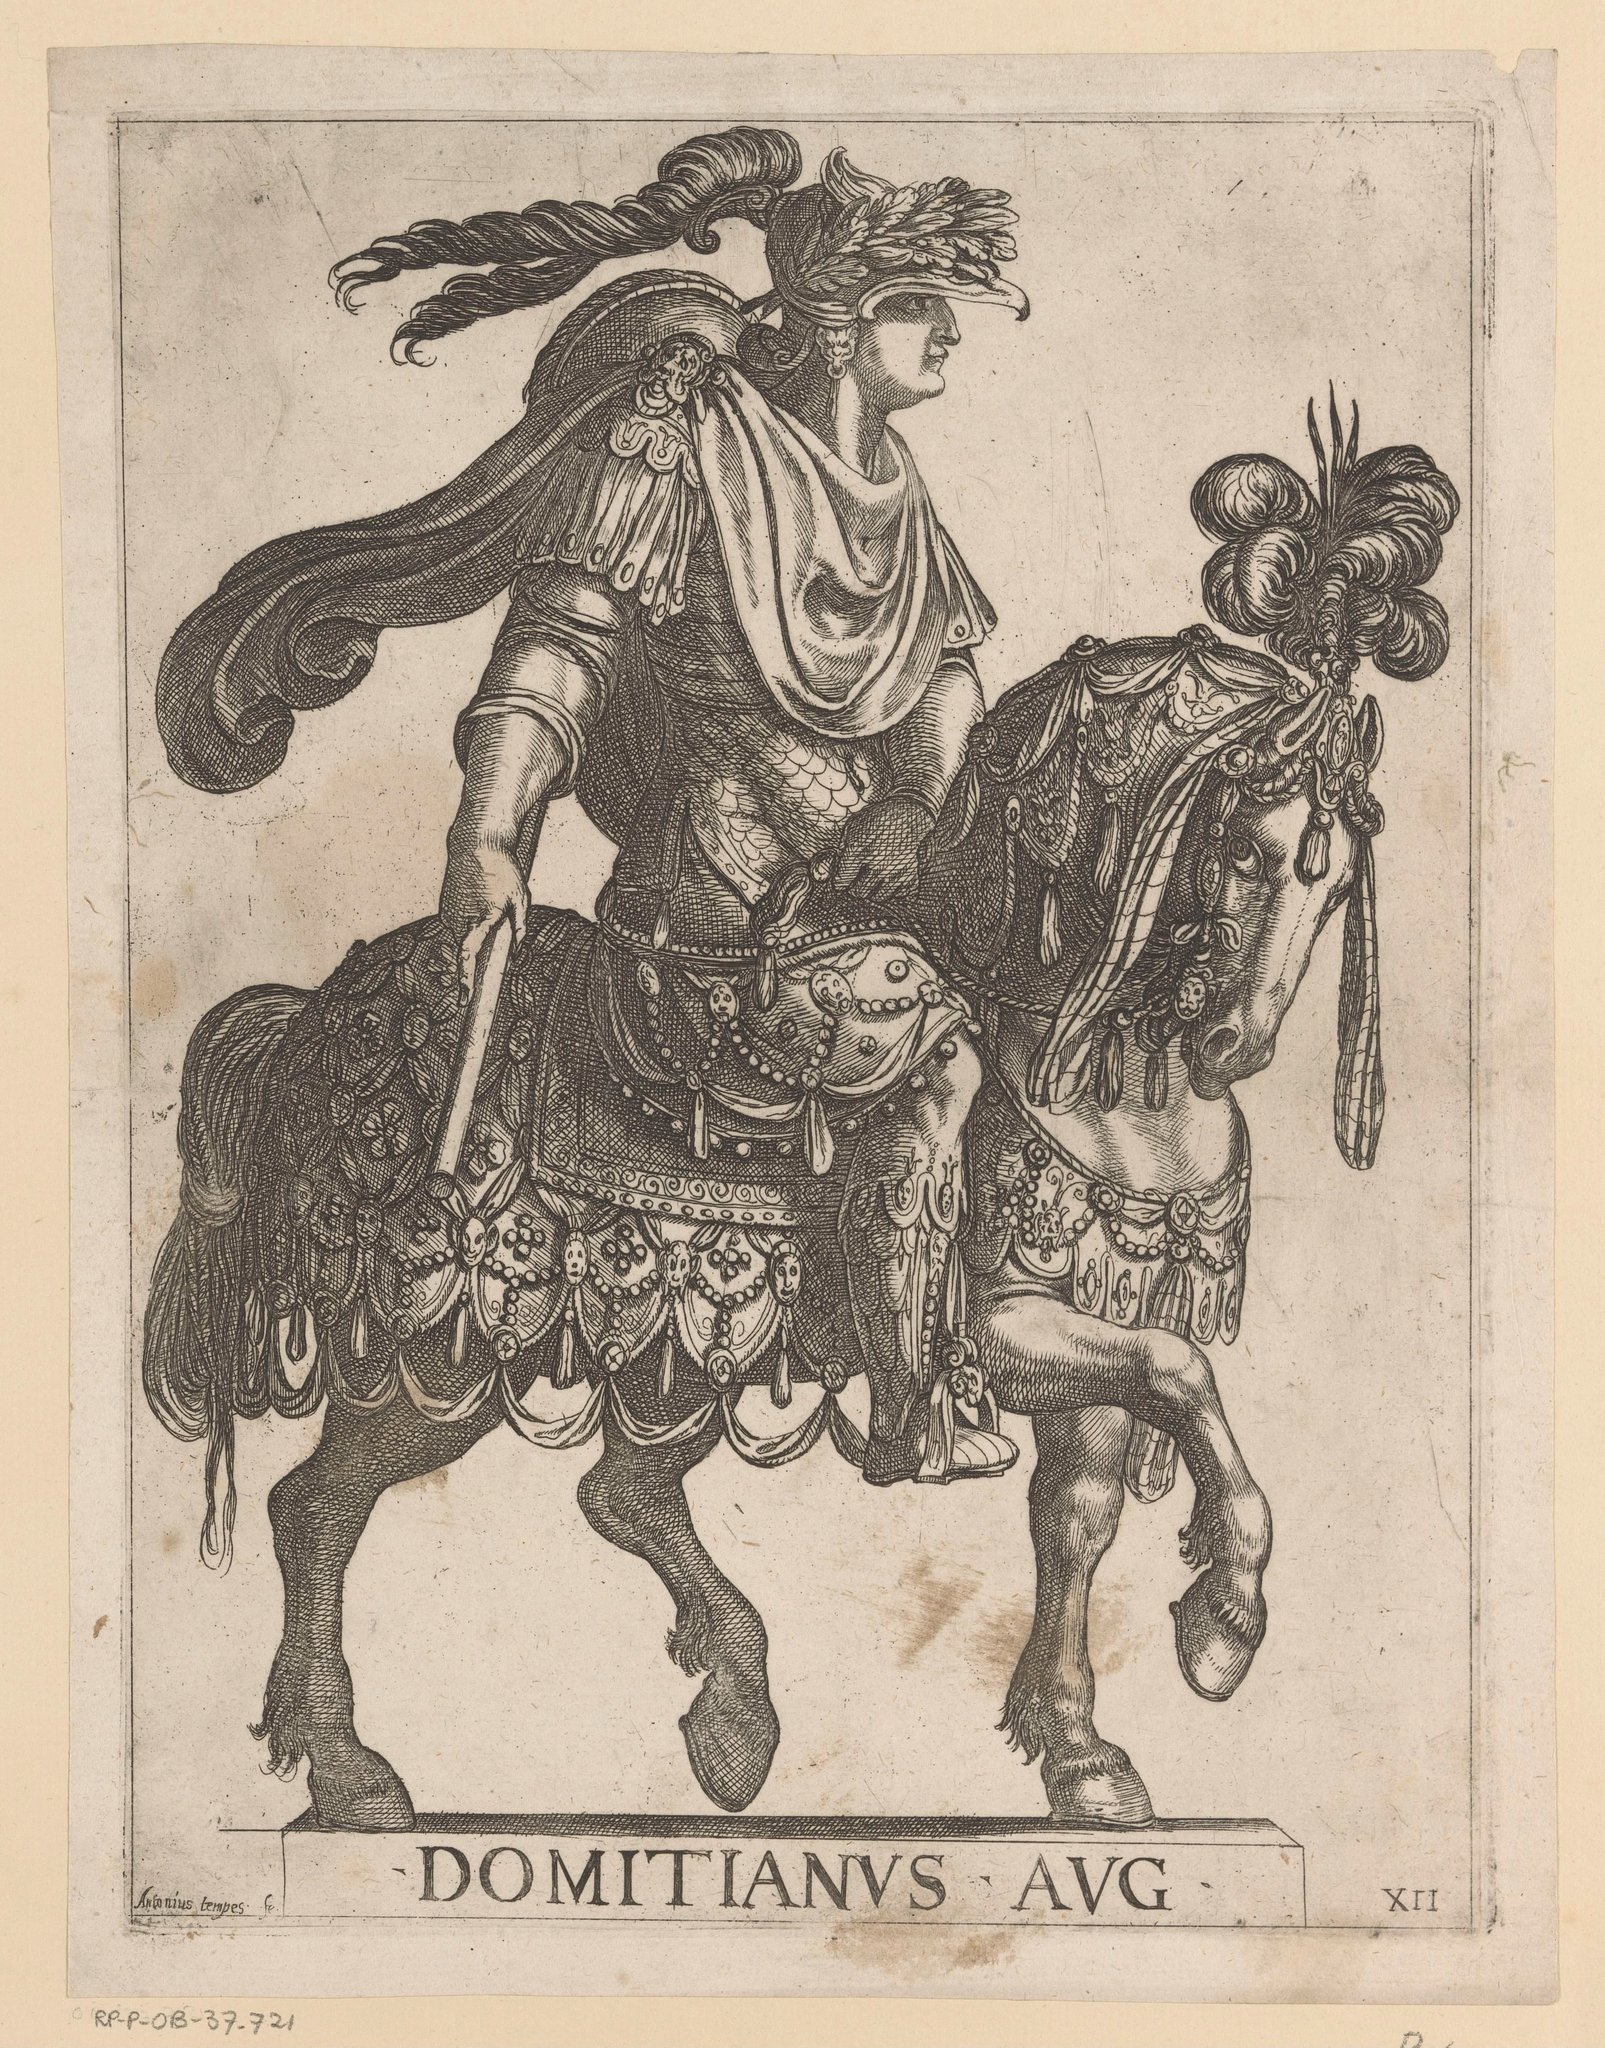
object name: print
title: Keizer Domitianus te paard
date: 1596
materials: paper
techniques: etching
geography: italy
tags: emperor, equestrian statue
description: Titelprent bij een reeks van twaalf prenten van Romeinse keizers.